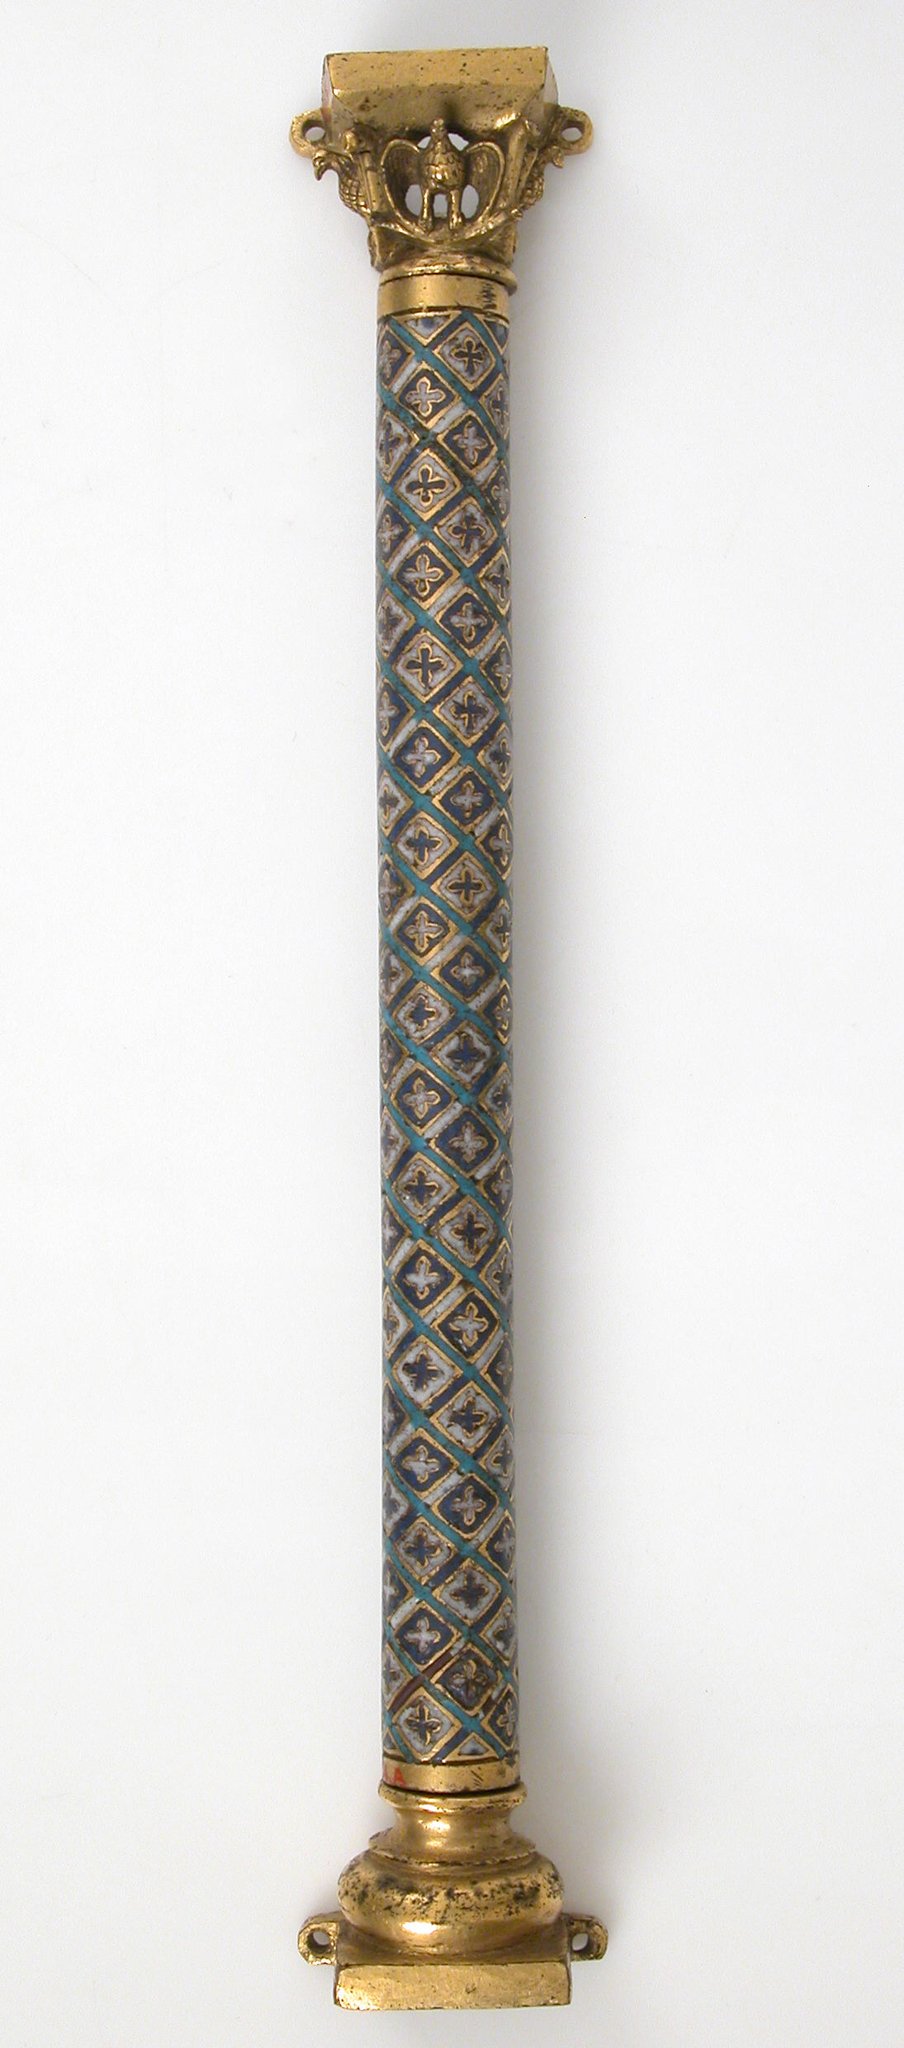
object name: colonnette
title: Colonnette from a Reliquary Shrine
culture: german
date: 1175-1200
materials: copper alloy, enamel, gilt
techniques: enamel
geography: germany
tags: birds